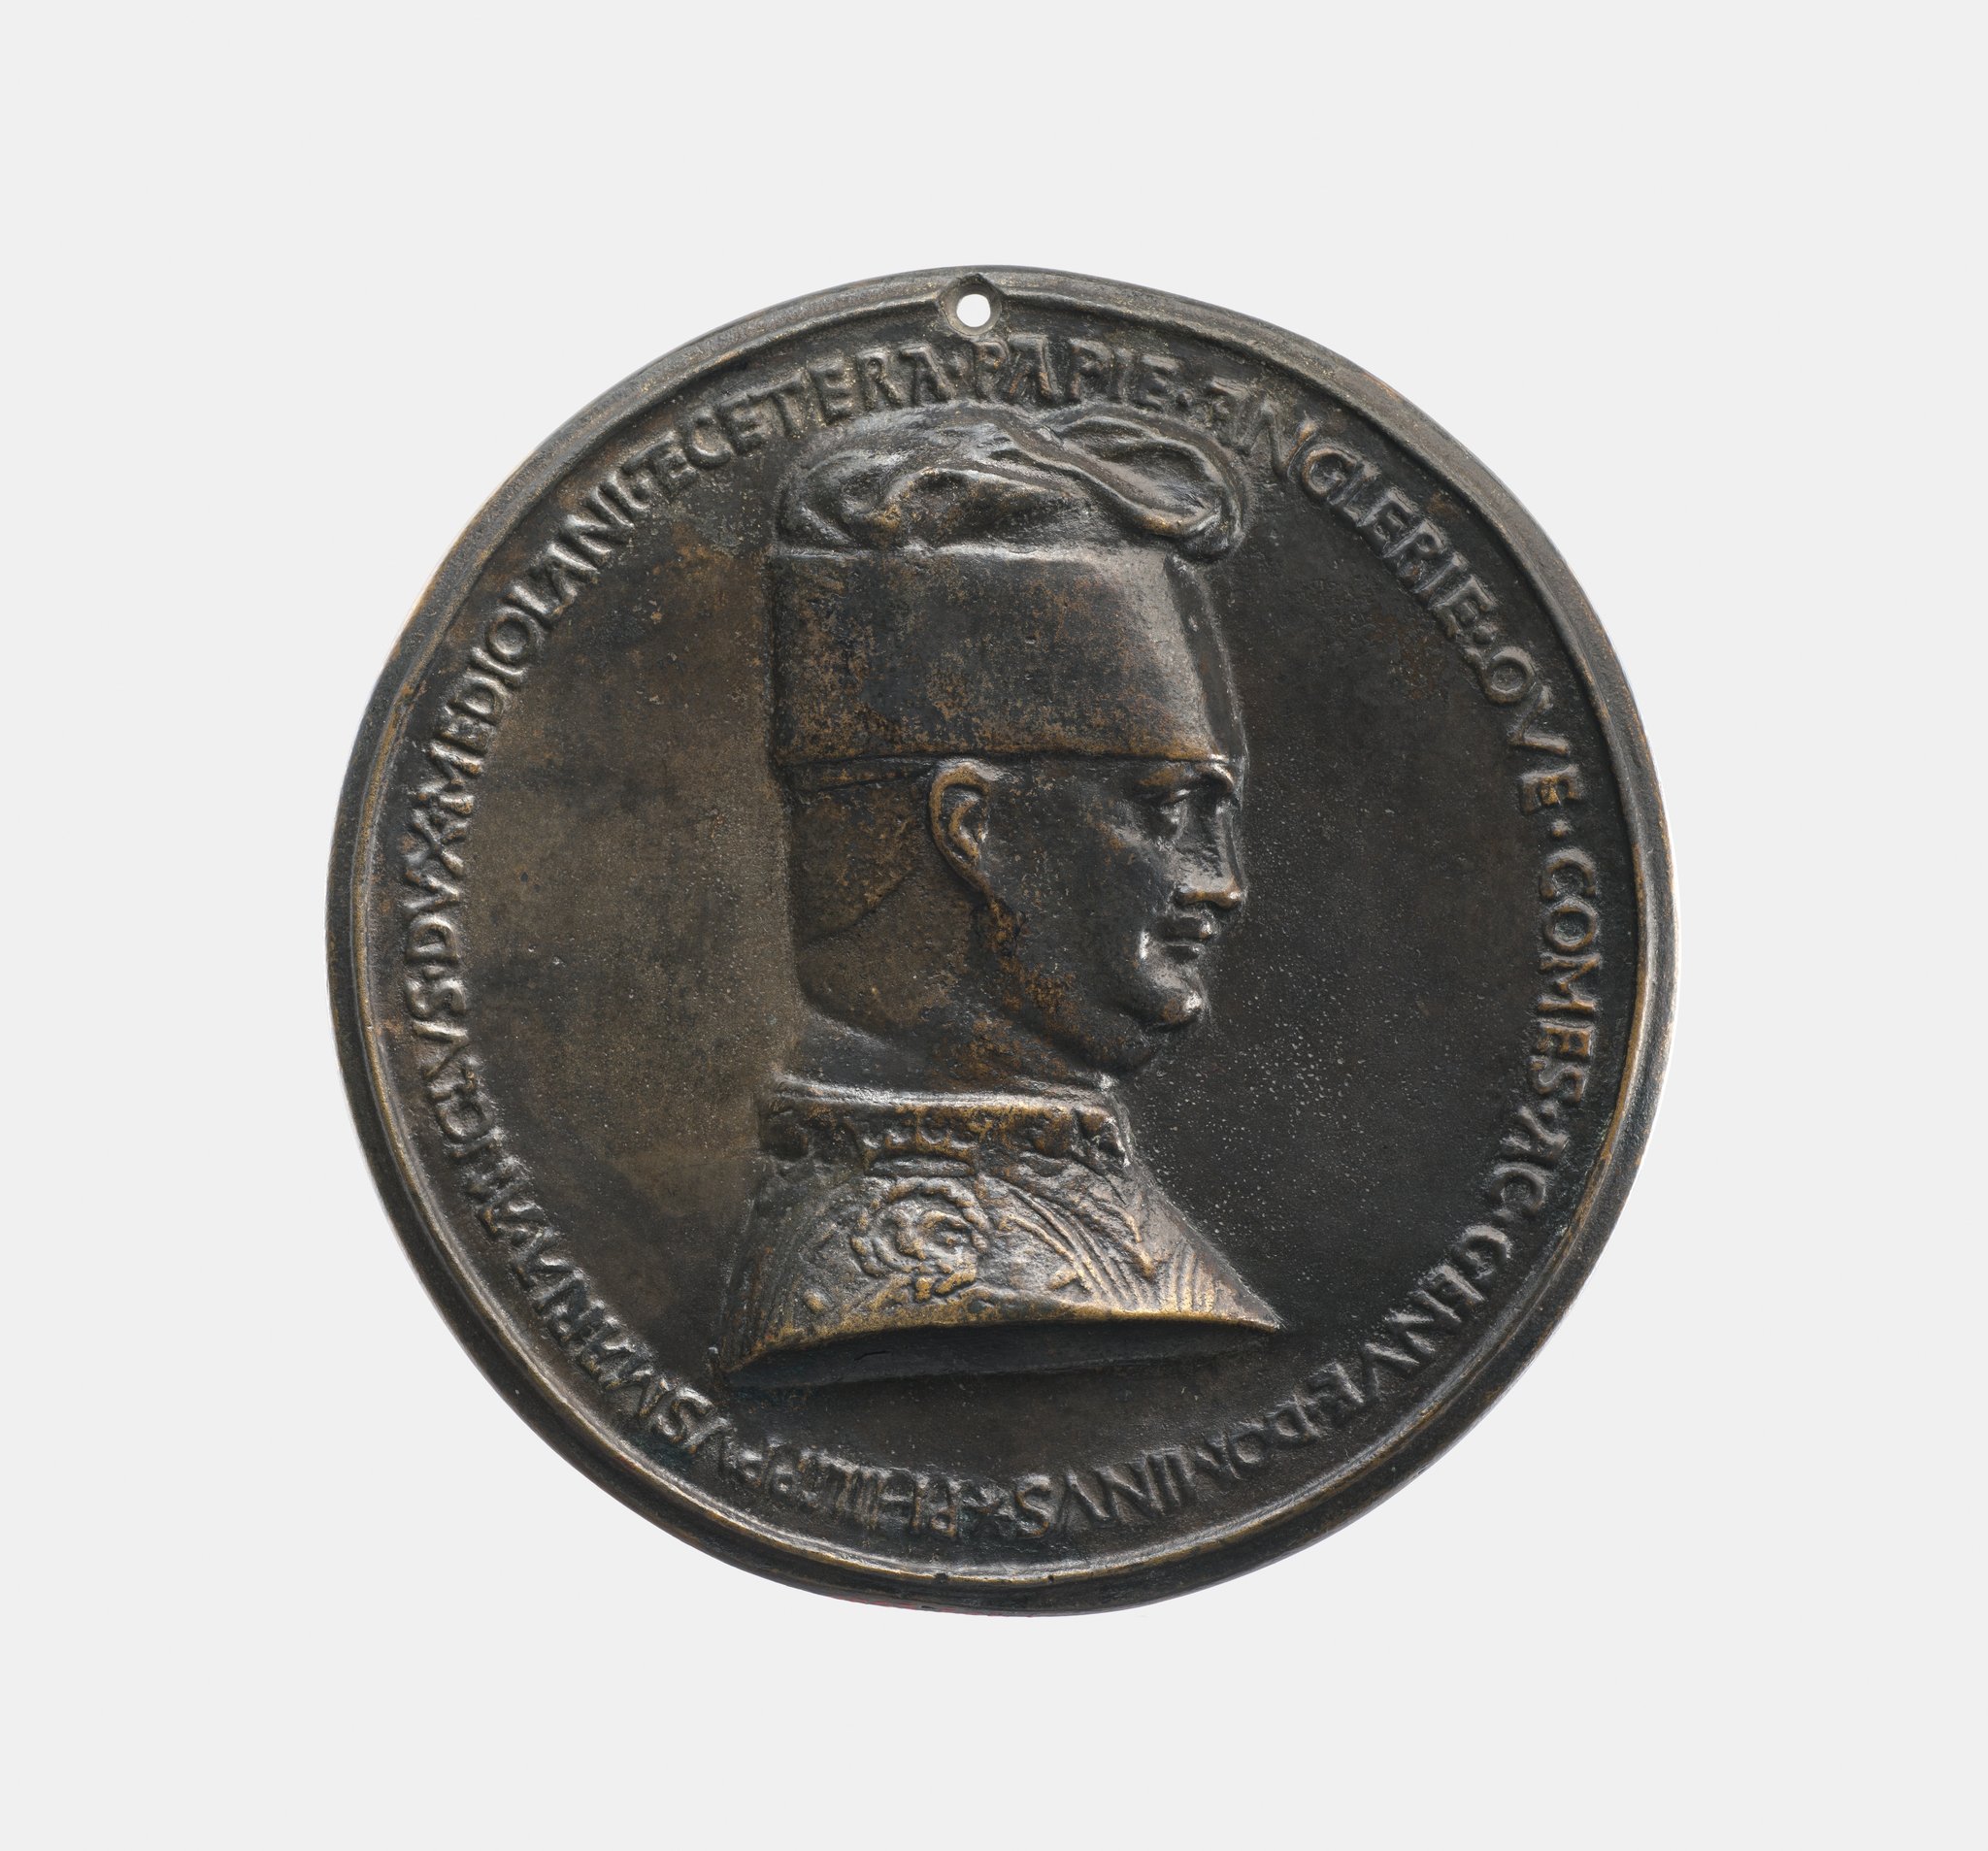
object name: medal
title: Filippo Maria Visconti 1392-1447, Duke of Milan 1412-47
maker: pisanello (antonio pisano)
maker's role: artist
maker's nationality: italian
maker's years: 1395-1455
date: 1441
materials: bronze